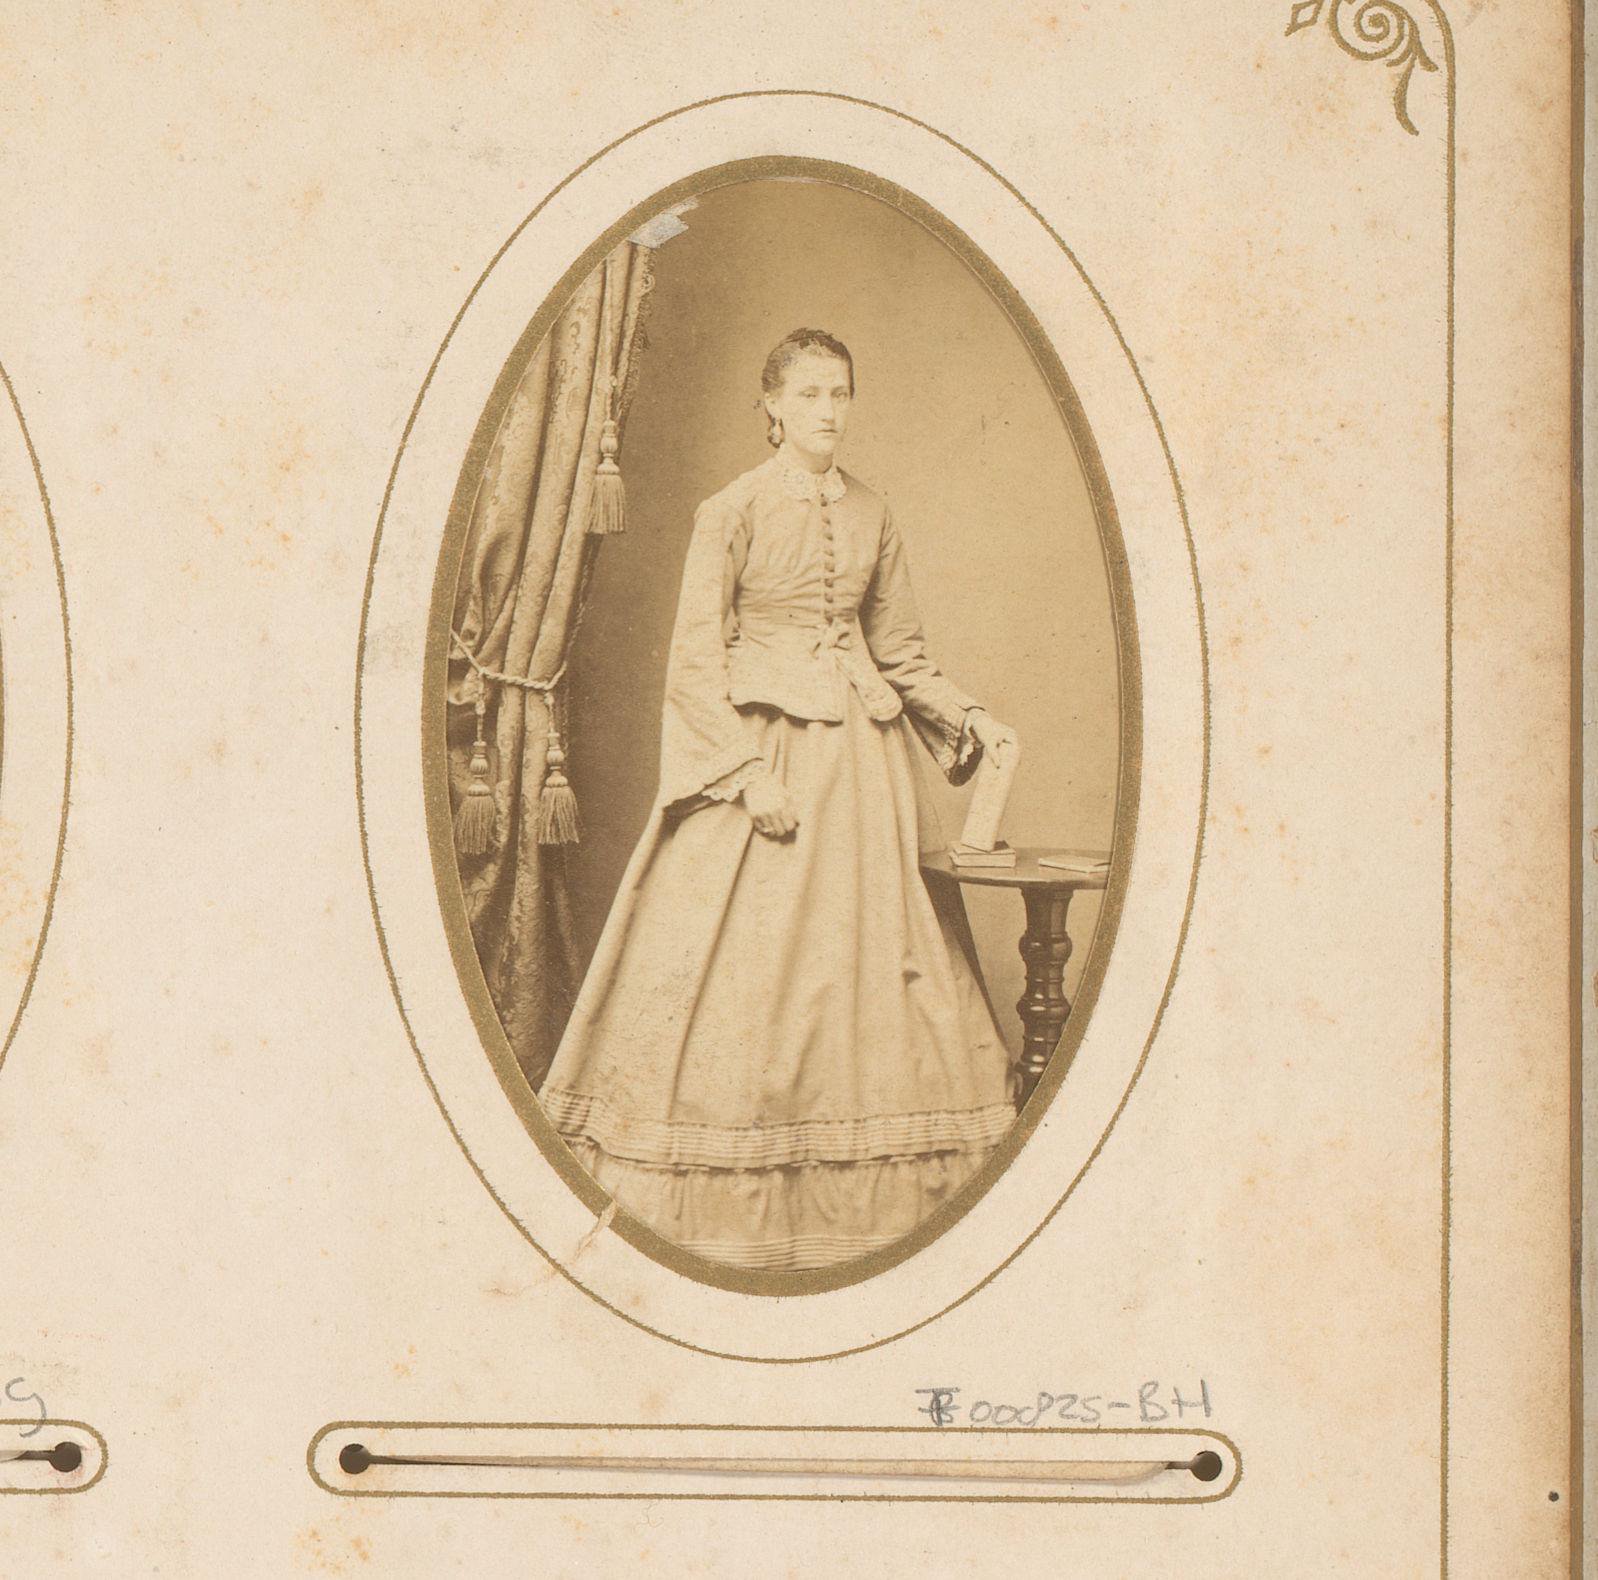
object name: album leaf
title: Portret van een jonge vrouw met boek in de hand, staand bij een tafel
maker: jan george mulder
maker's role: fotograaf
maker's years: 1816-1895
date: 1865-1887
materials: cardboard, photographic support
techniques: albumen print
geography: haarlem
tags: adolescent, young woman, maiden, historical persons - bb - woman, table, book, standing figure - aa - female human figure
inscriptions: inscription: ‘Photographisch/ Atelier/ van/ J. G. Mulder./ Lange Bagijnestraat/ Haarlem./ De plaat blijft tot nabestelling bewaard’